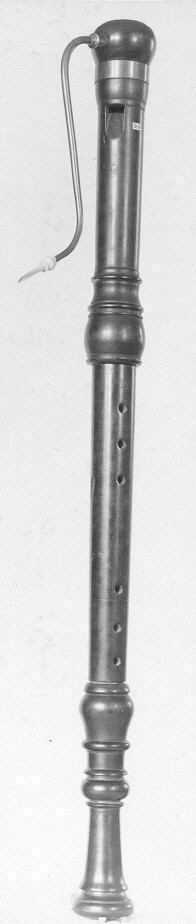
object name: bass recorder in f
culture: german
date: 1801-1900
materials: brass, ivory, wood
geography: germany